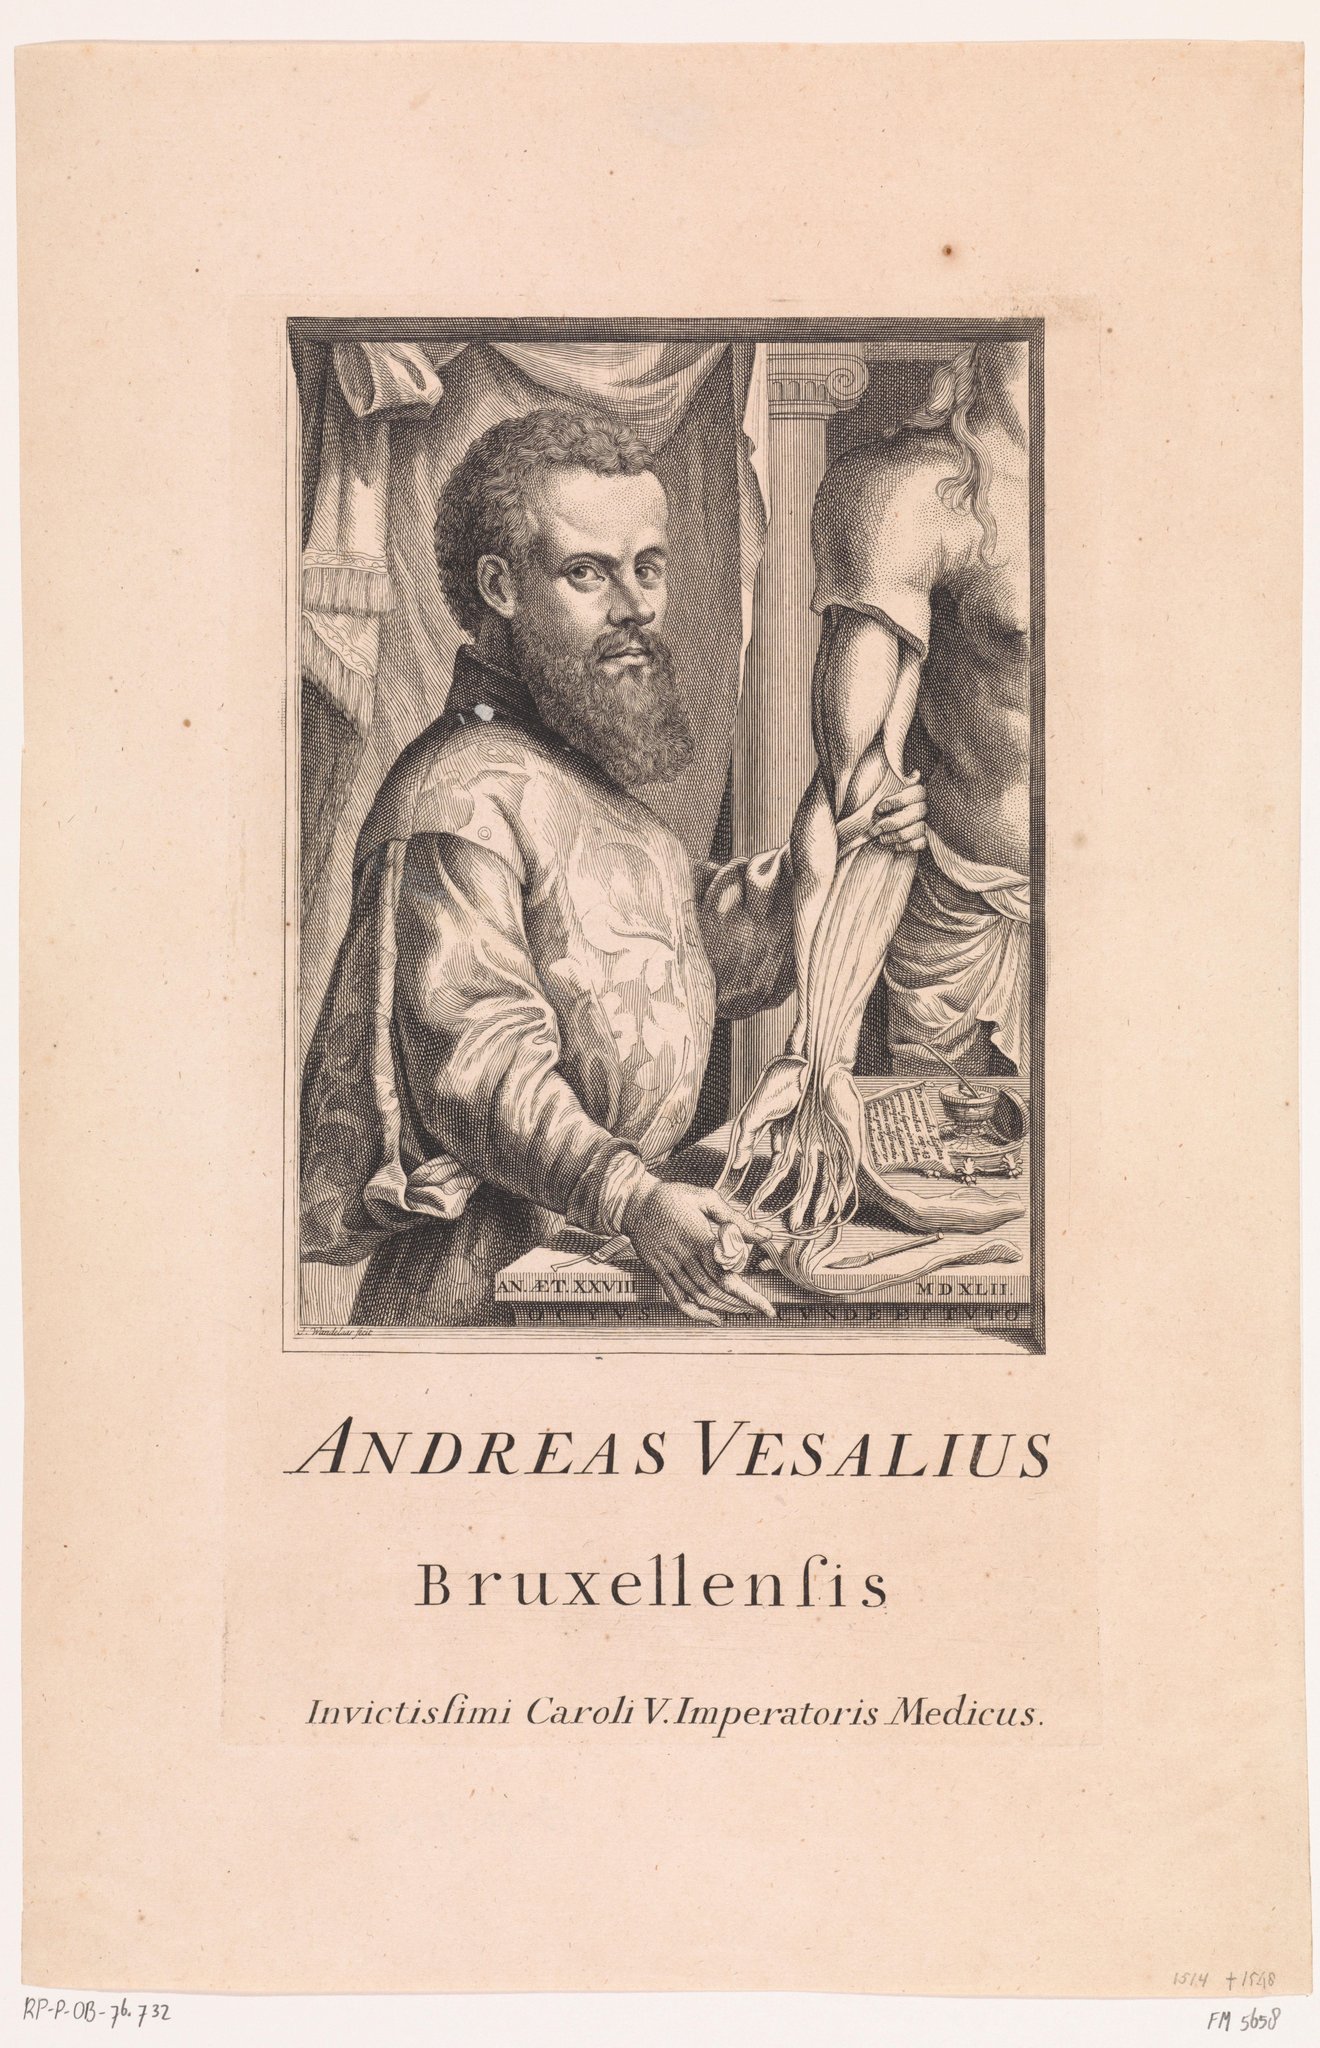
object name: print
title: Portret van Andreas Vesalius (Andries van Wesel), op 28-jarige leeftijd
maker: jan wandelaar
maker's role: draughtsman, print maker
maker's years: 1690-1759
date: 1702-1759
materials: paper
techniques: engraving, etching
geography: northern netherlands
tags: brussels, dissection, writing tools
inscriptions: collector's mark: Lugt 2228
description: De anatoom Andreas Vesalius ontleedt een arm. Op de tafel voor hem een Latijnse tekst en een inktpot.